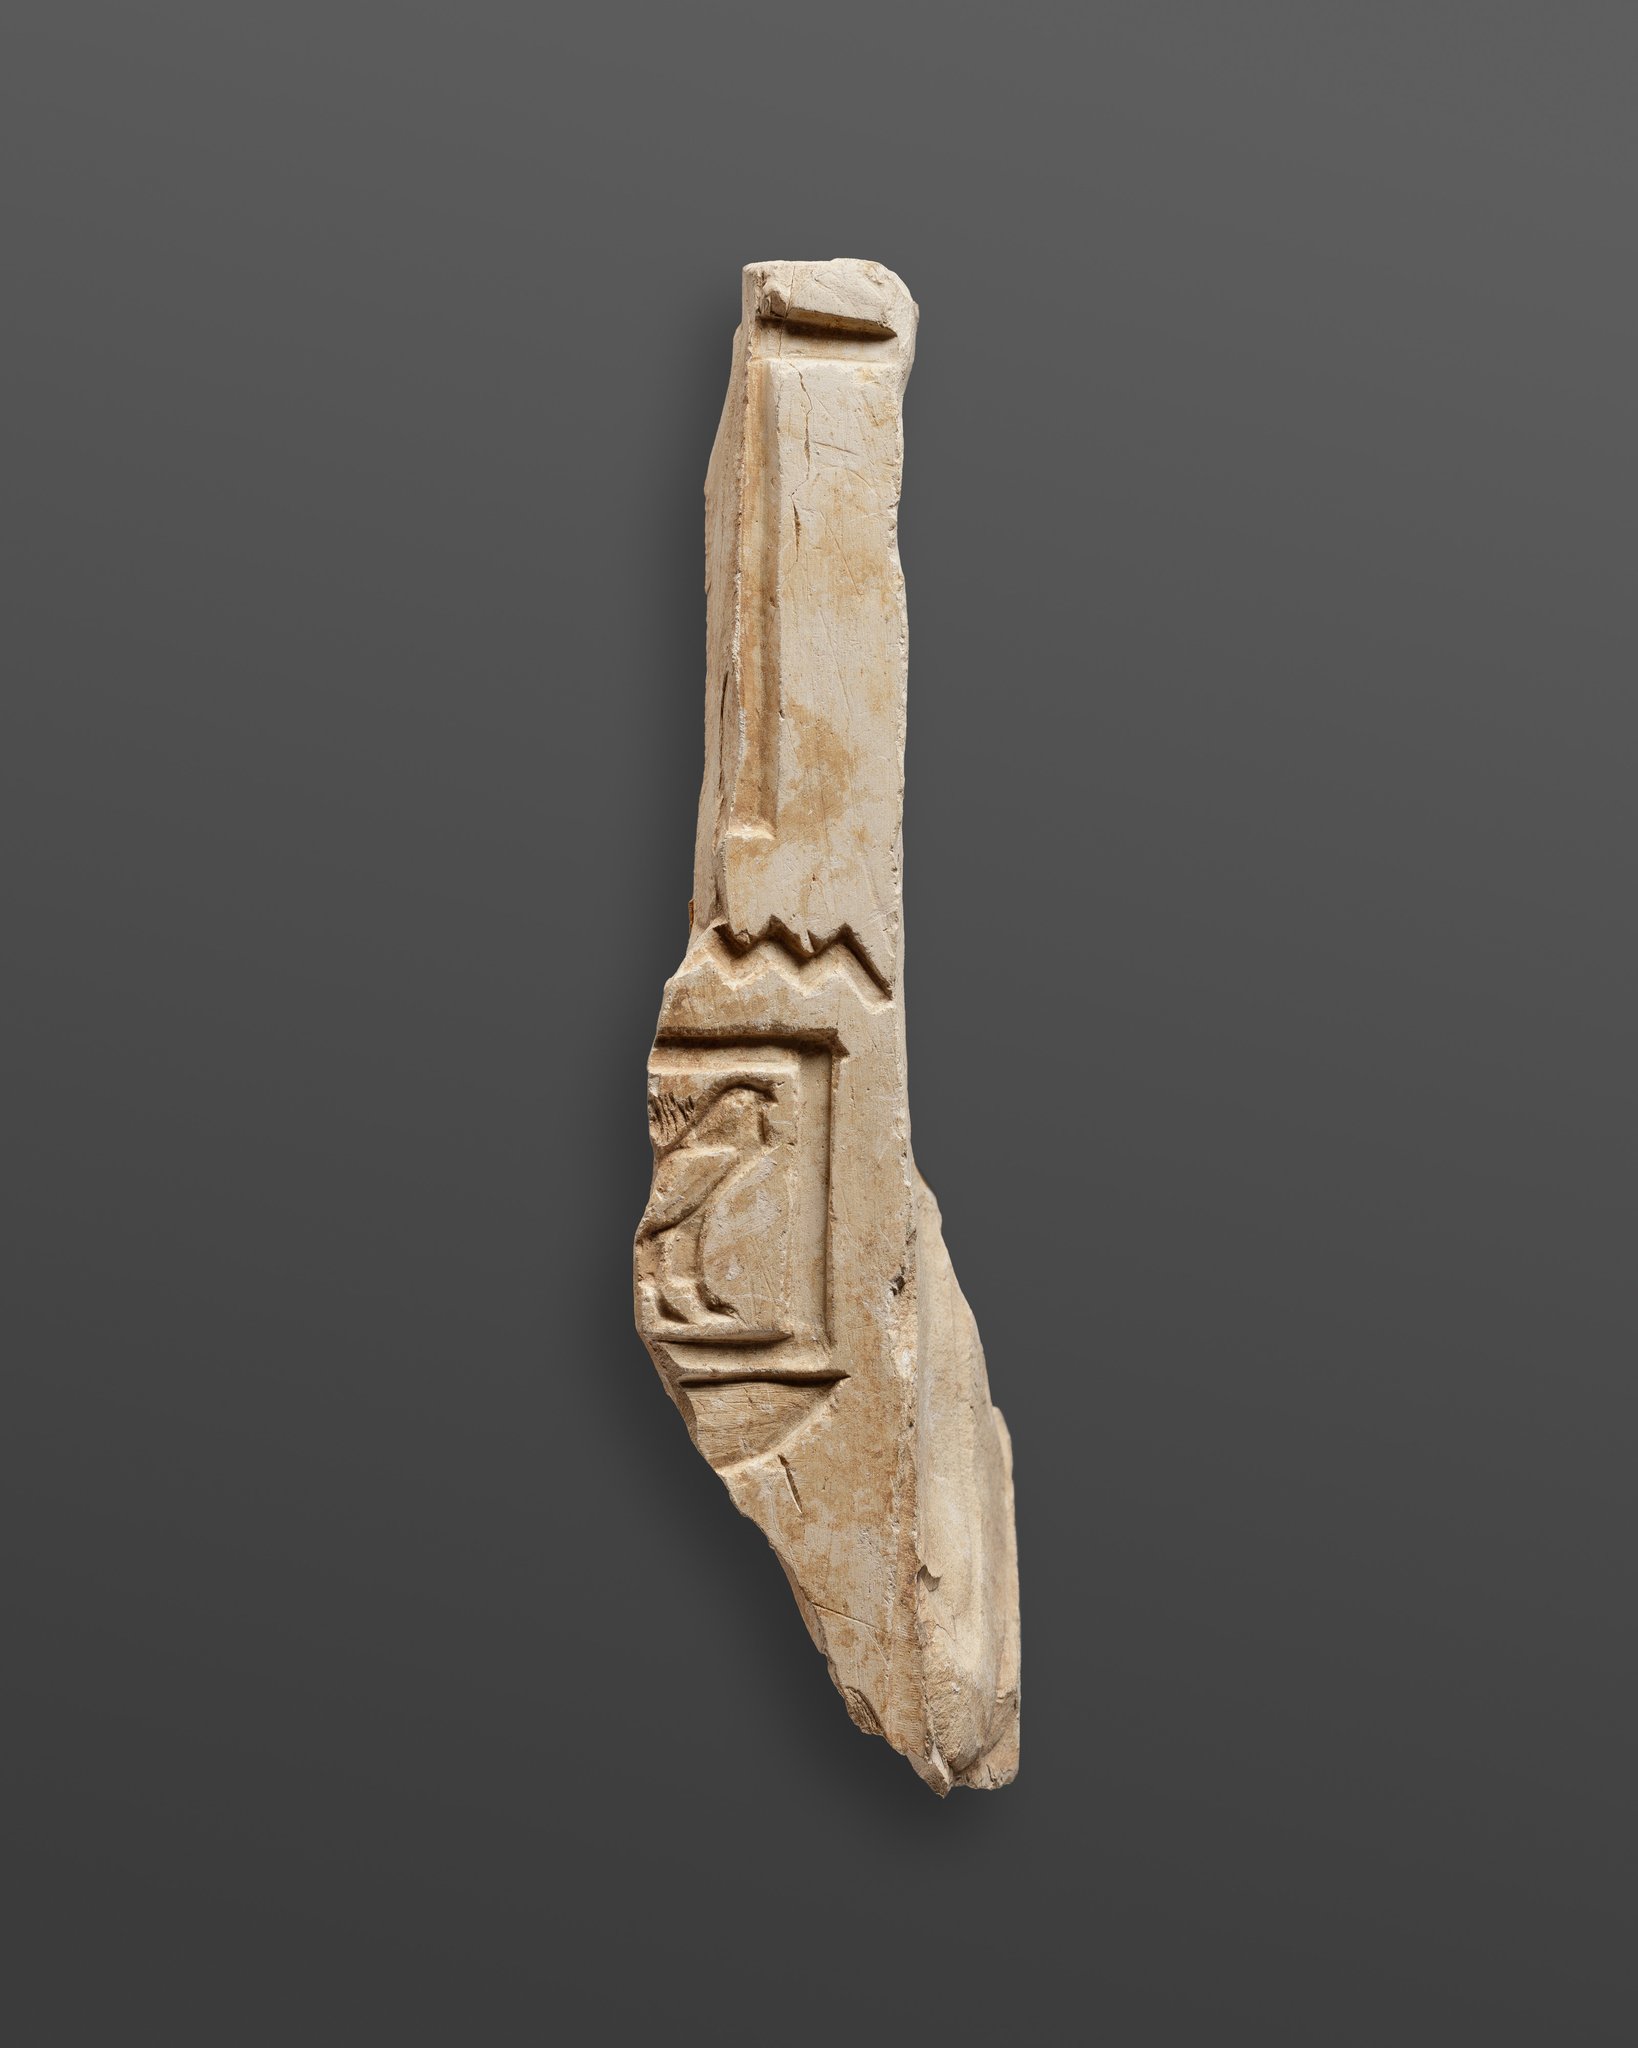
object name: relief fragment, hathor inscription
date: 2100-2090 BCE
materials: limestone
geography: egypt